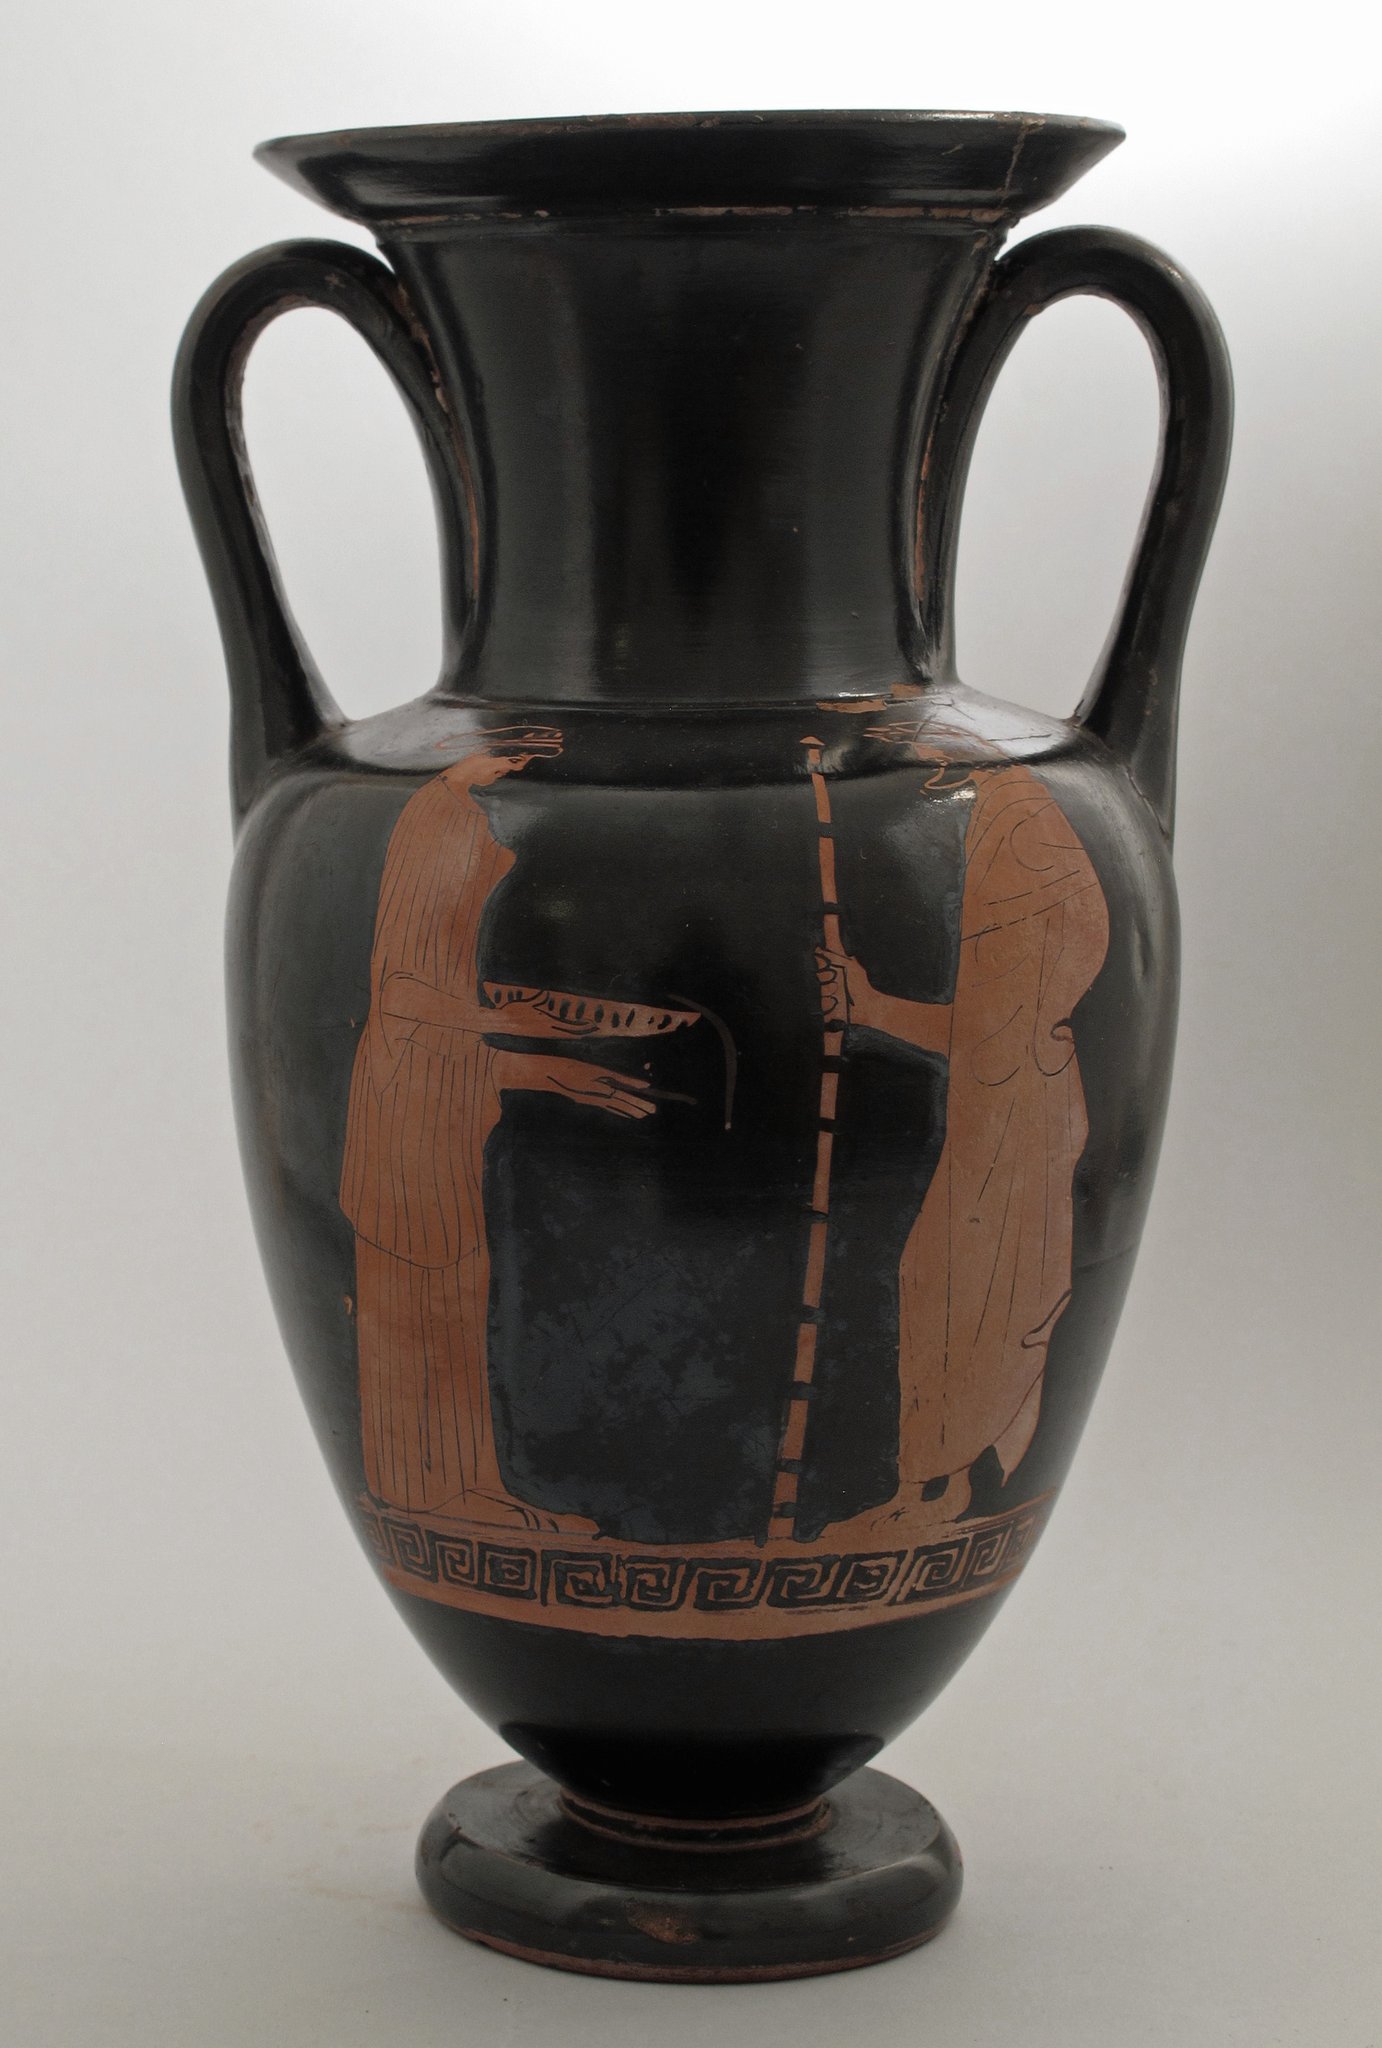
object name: neck amphora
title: Neck-amphora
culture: greek, attic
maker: richmond painter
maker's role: artist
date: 440 BCE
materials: terracotta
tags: women